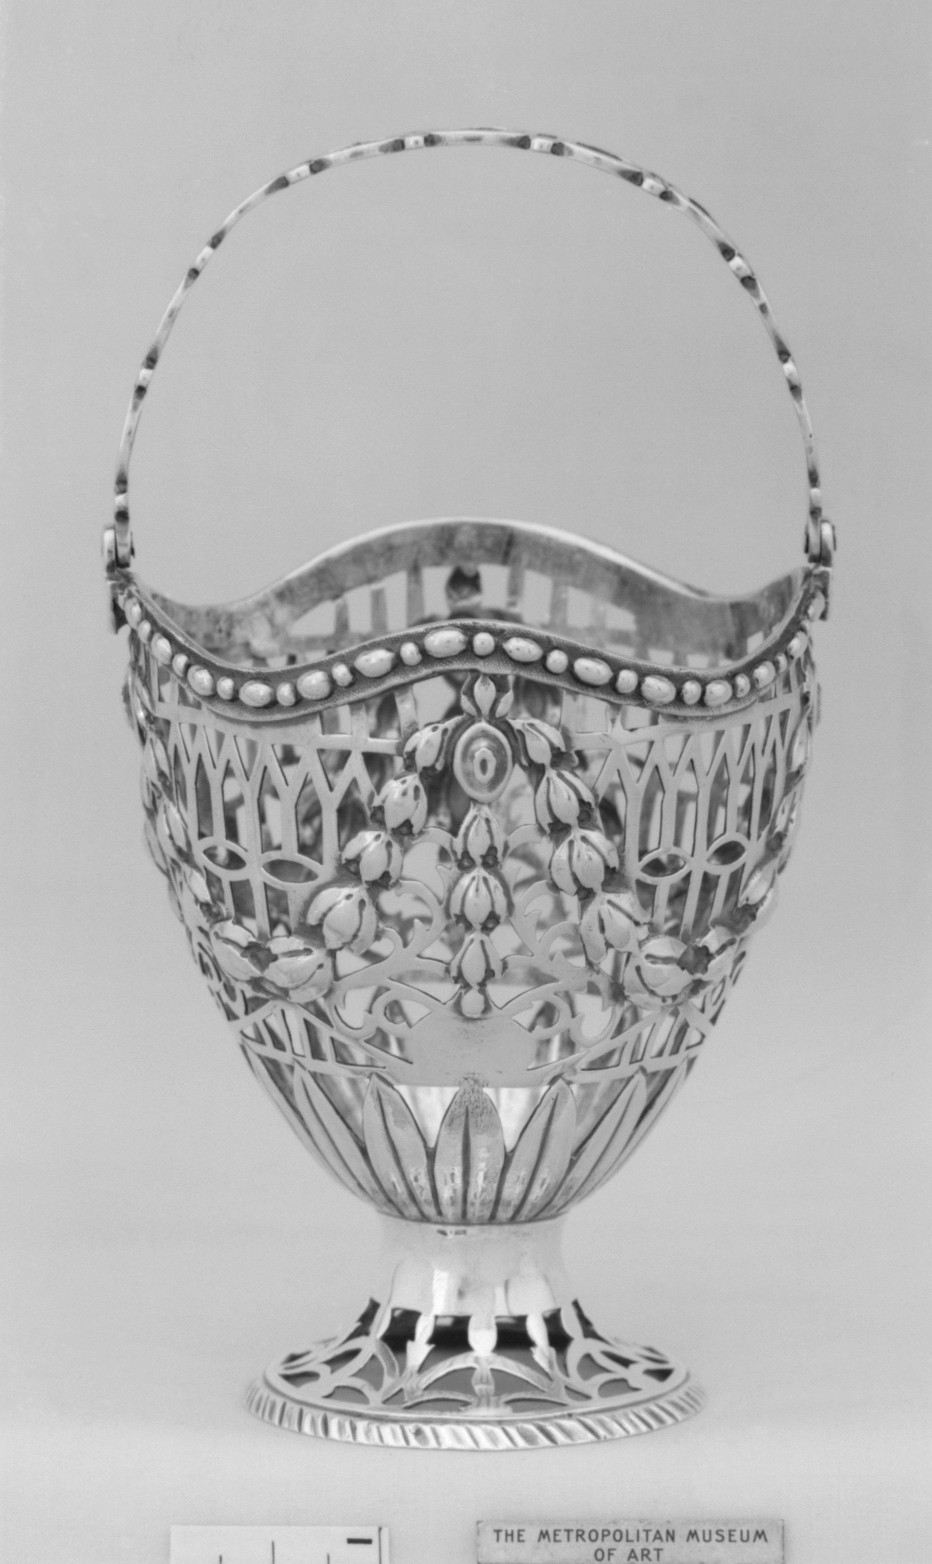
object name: sugar bowl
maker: mary makemeid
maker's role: maker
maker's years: 1773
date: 1775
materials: glass, silver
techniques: lining